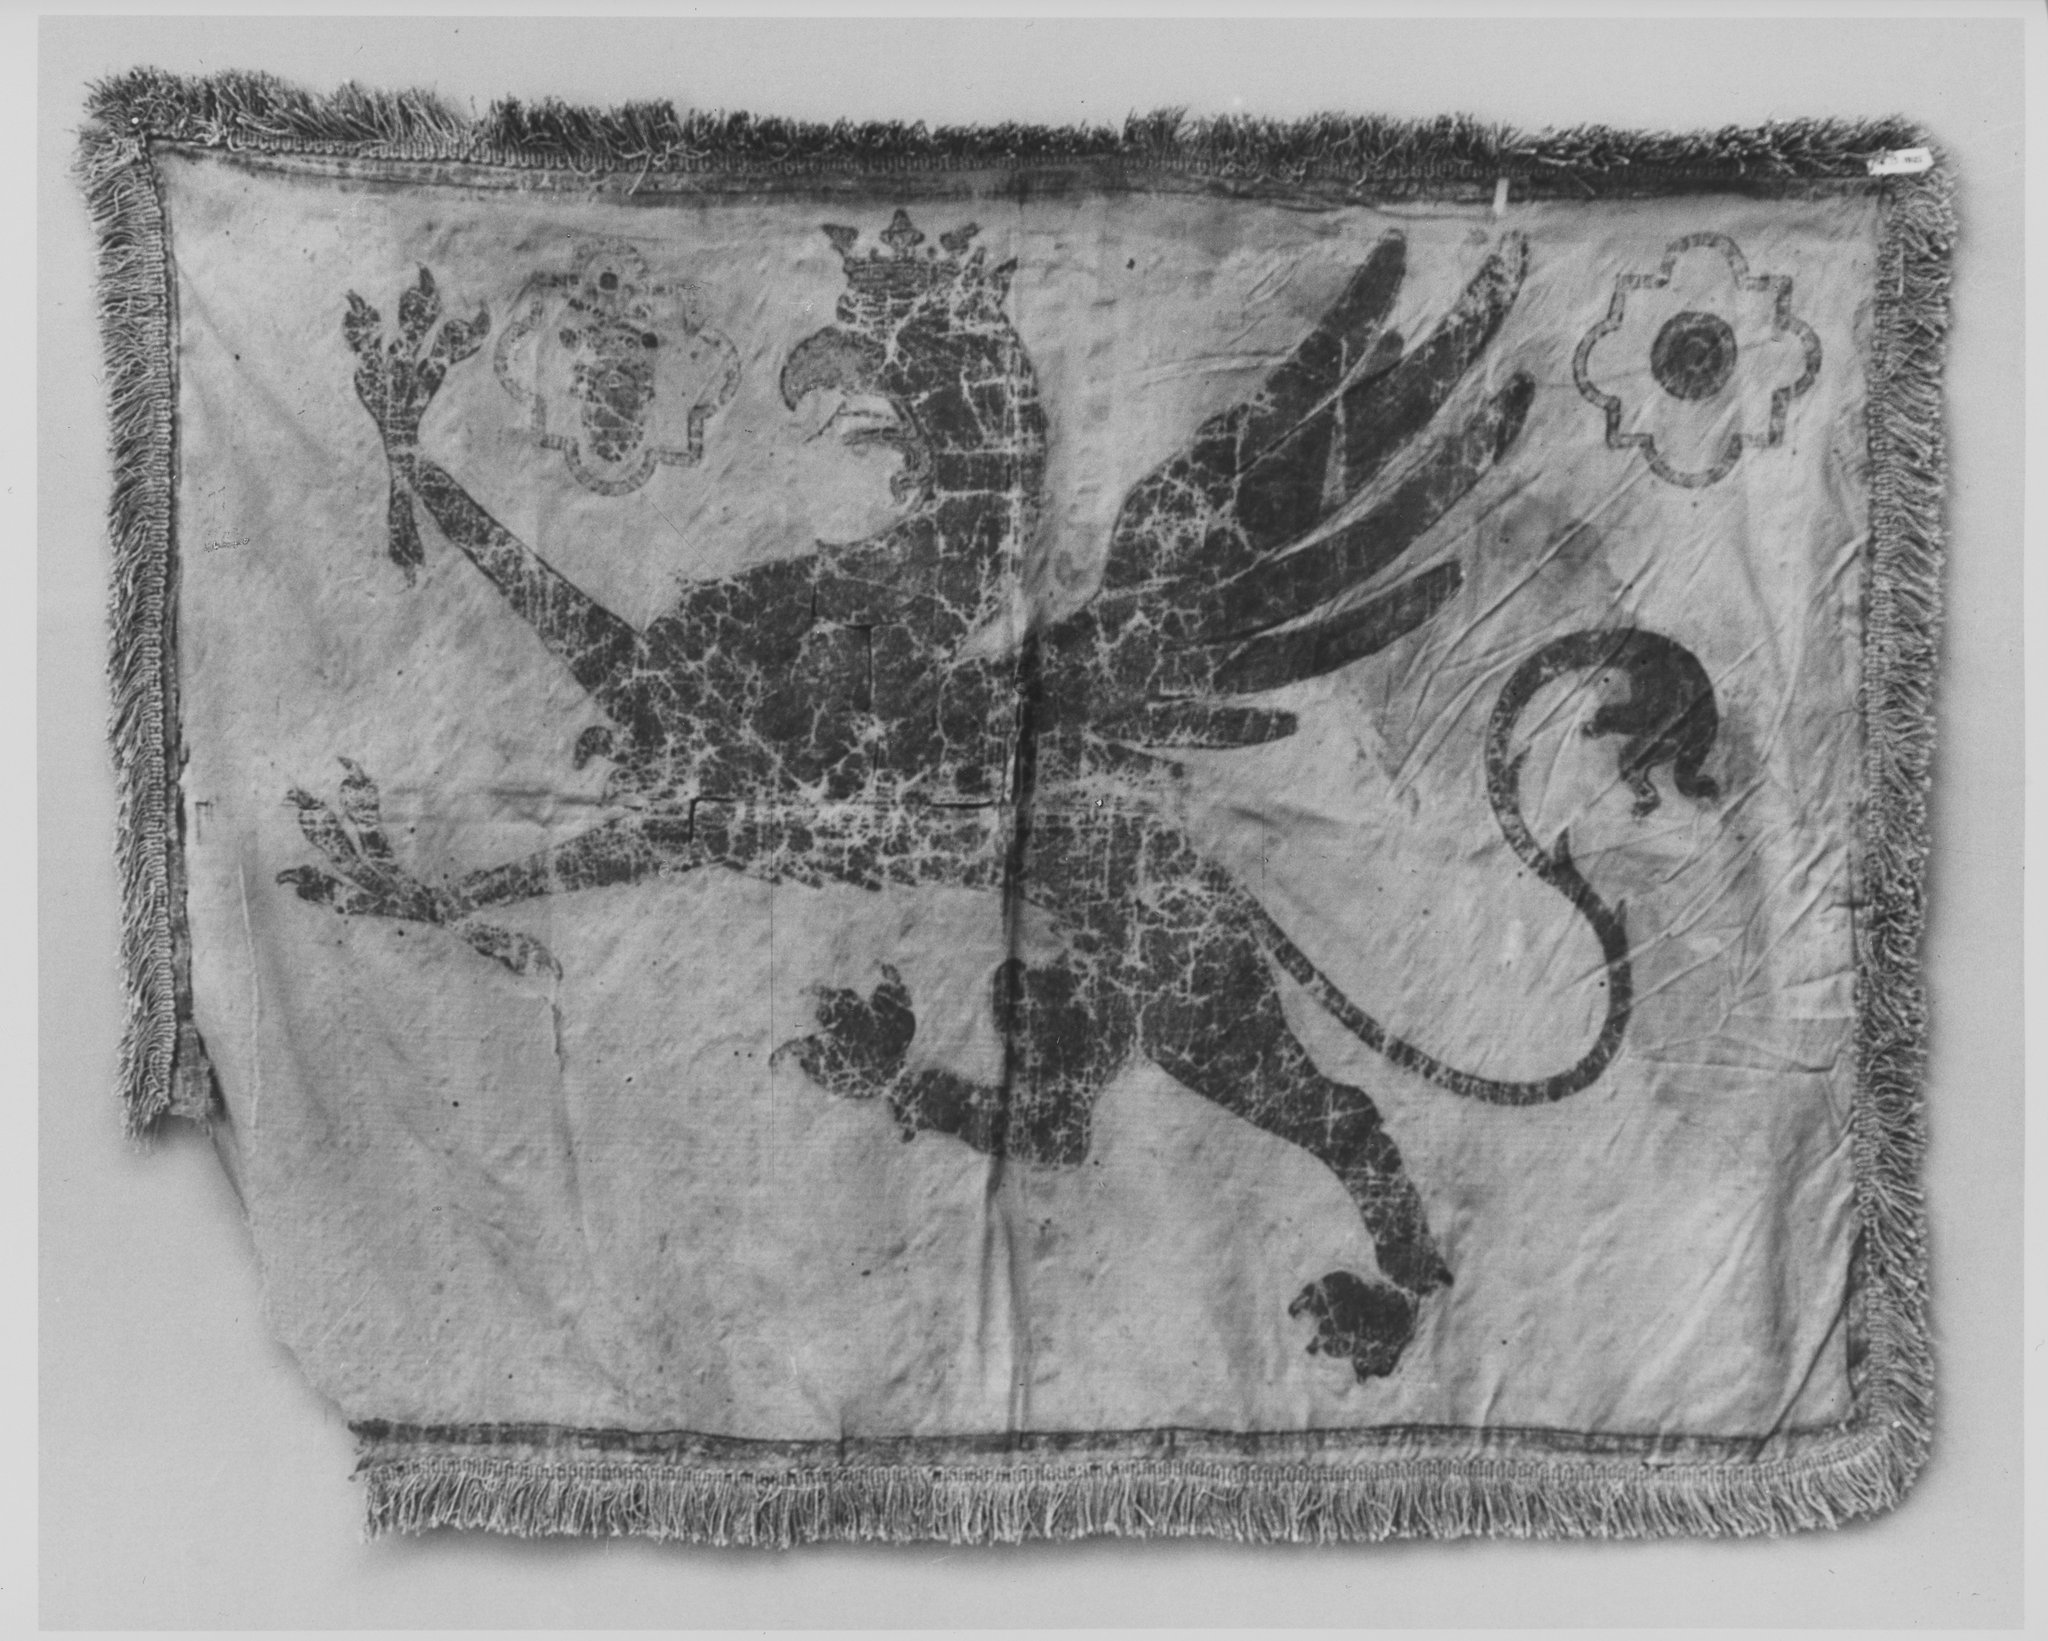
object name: banner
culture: italian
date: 1501-1600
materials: silk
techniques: polychromy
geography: italy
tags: griffins